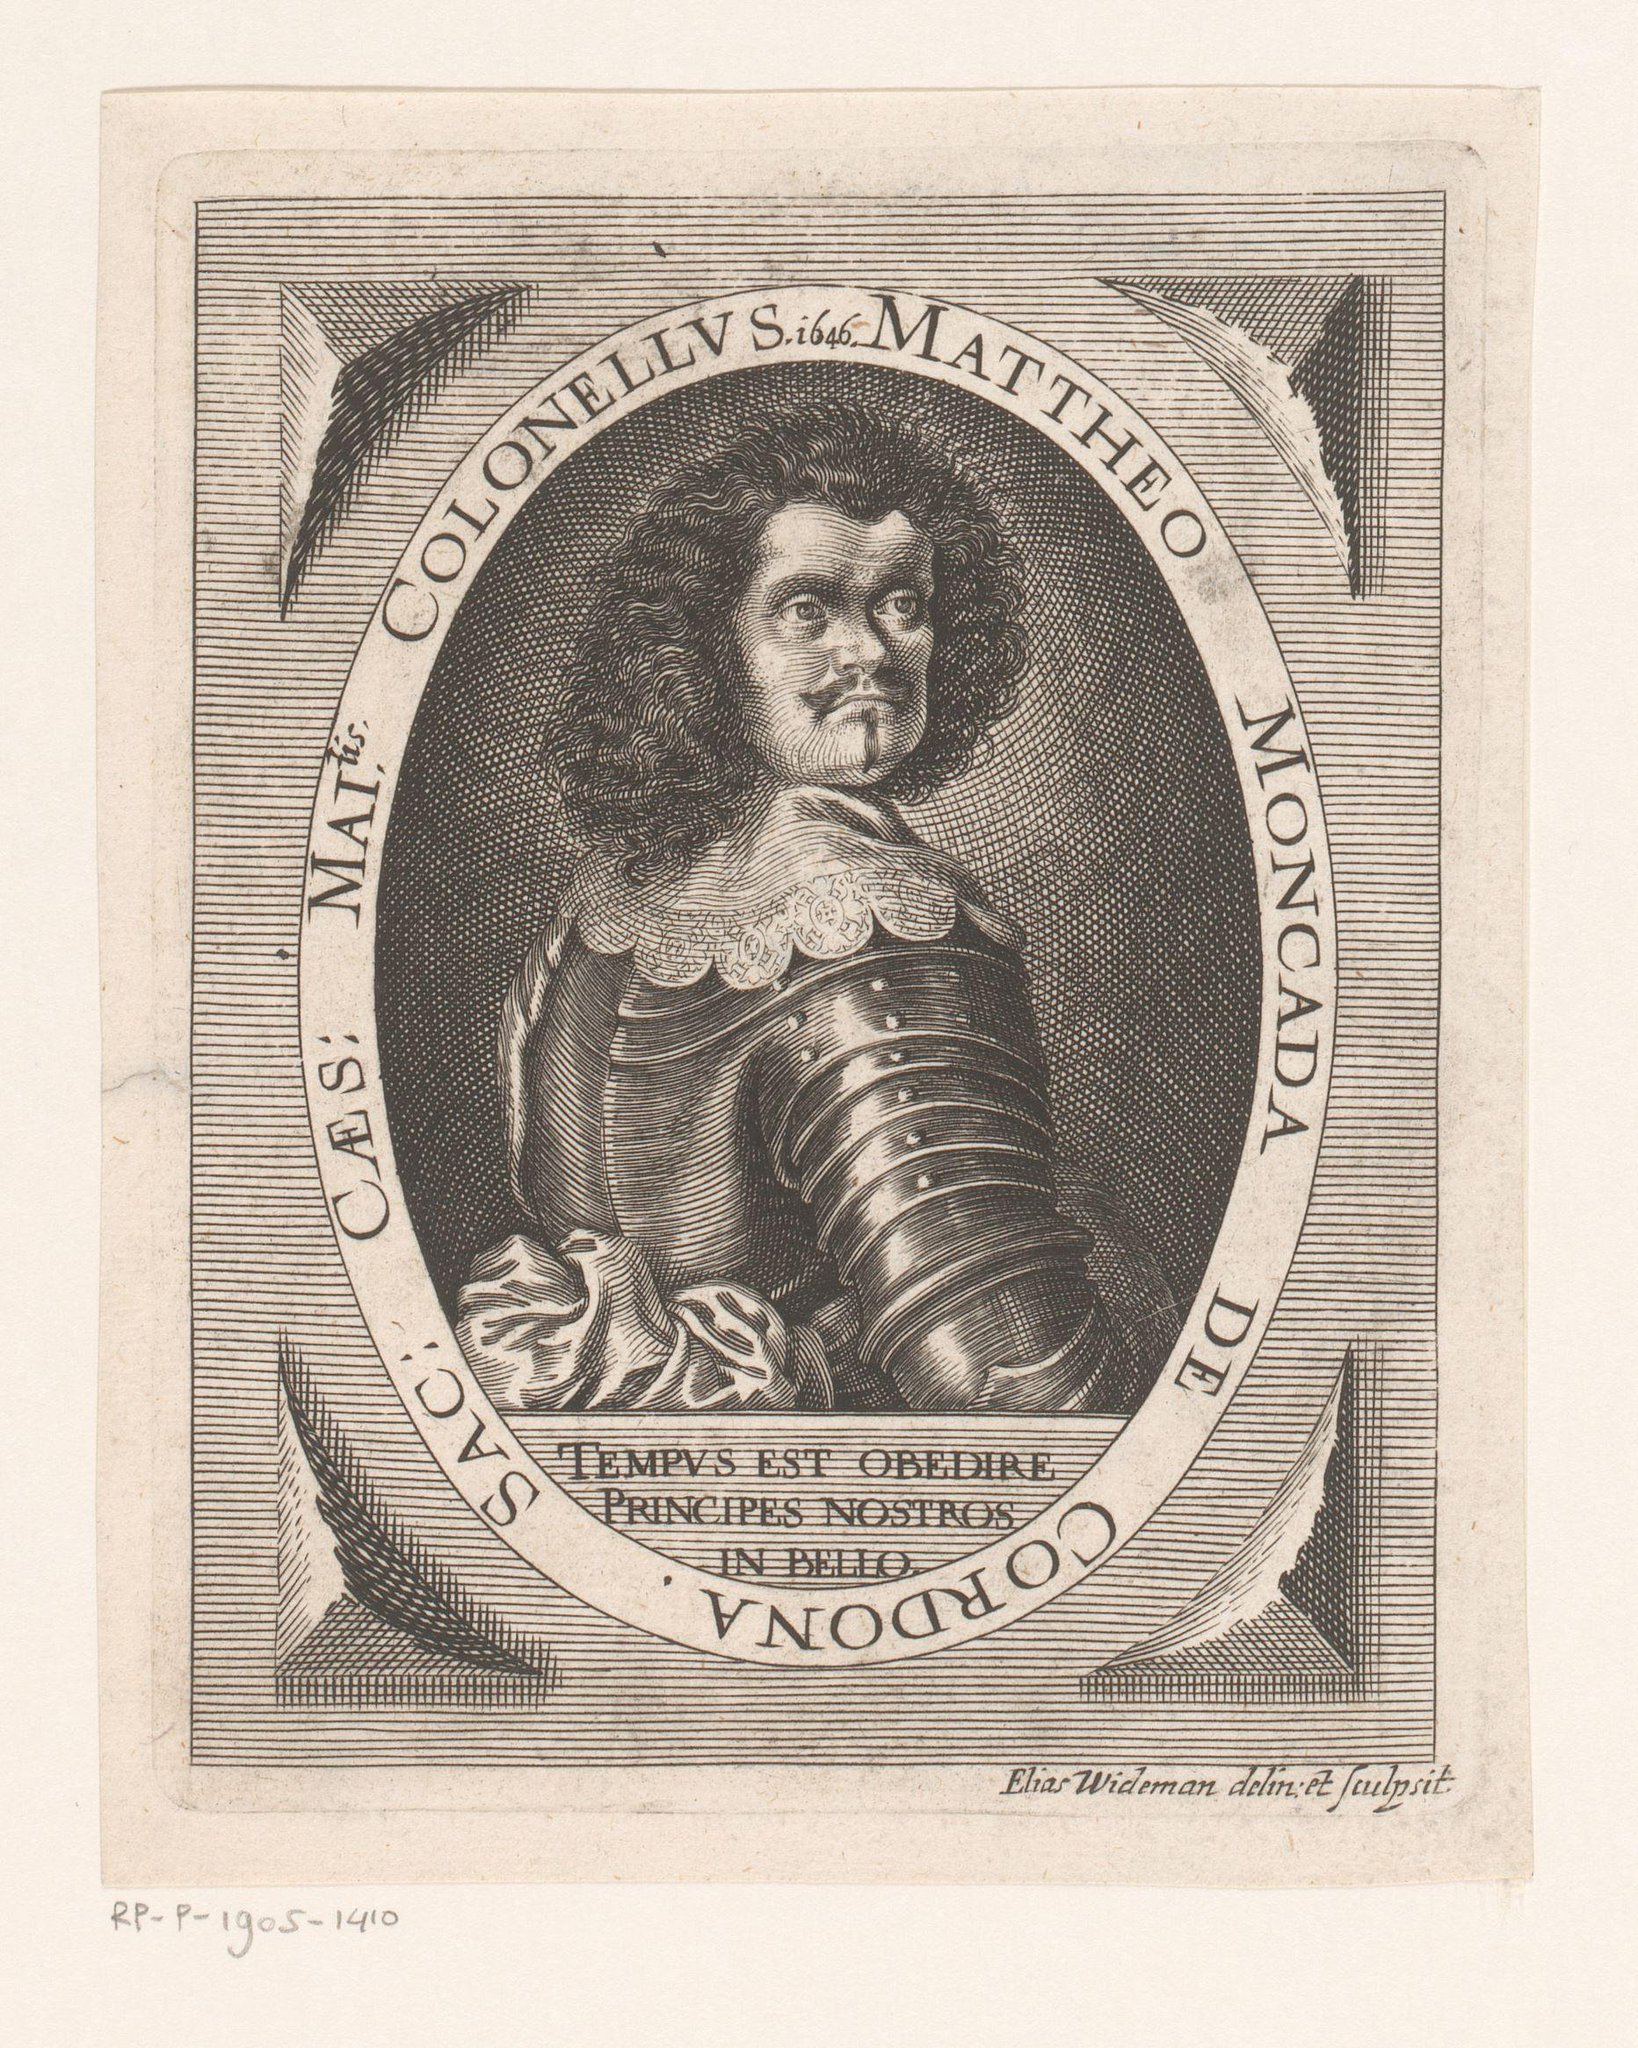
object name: print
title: Portret van Mateo de Moncada de Cardona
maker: elias widemann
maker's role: print maker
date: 1646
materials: paper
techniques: engraving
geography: vienna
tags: historical persons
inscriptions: collector's mark: Lugt 2228